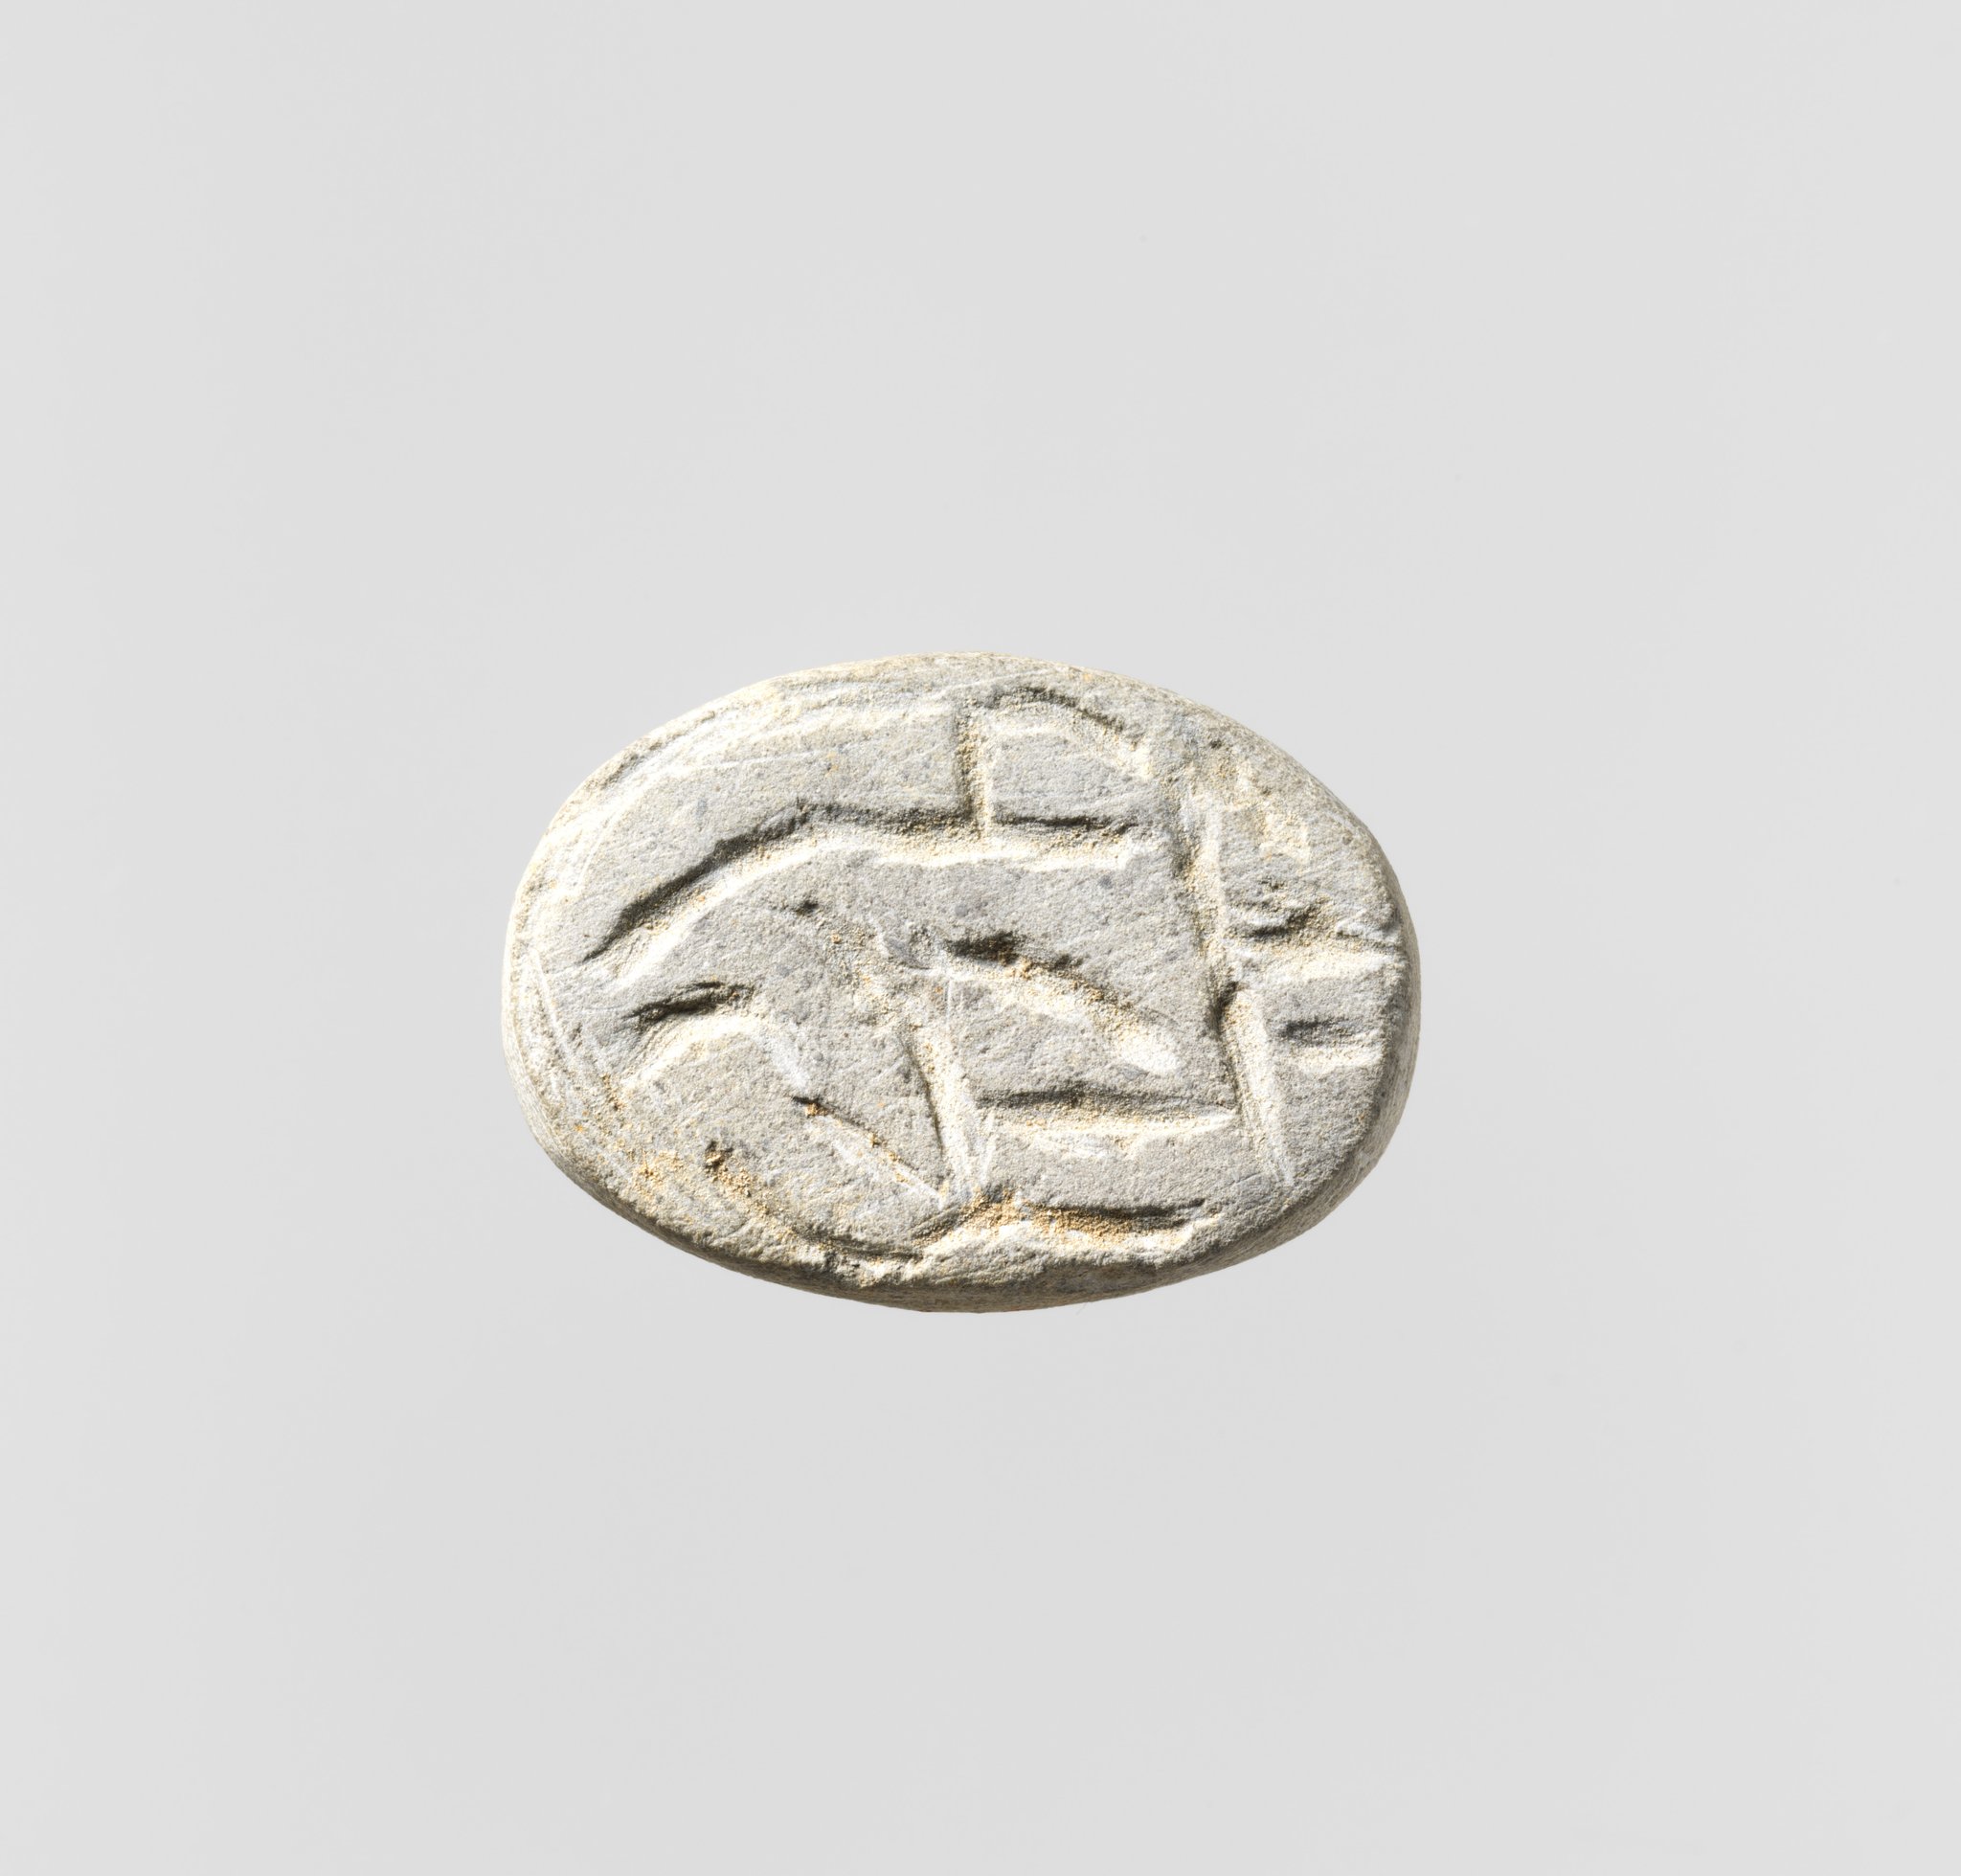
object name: stamp, disk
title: Stamp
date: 1295-1070 BCE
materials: limestone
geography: egypt